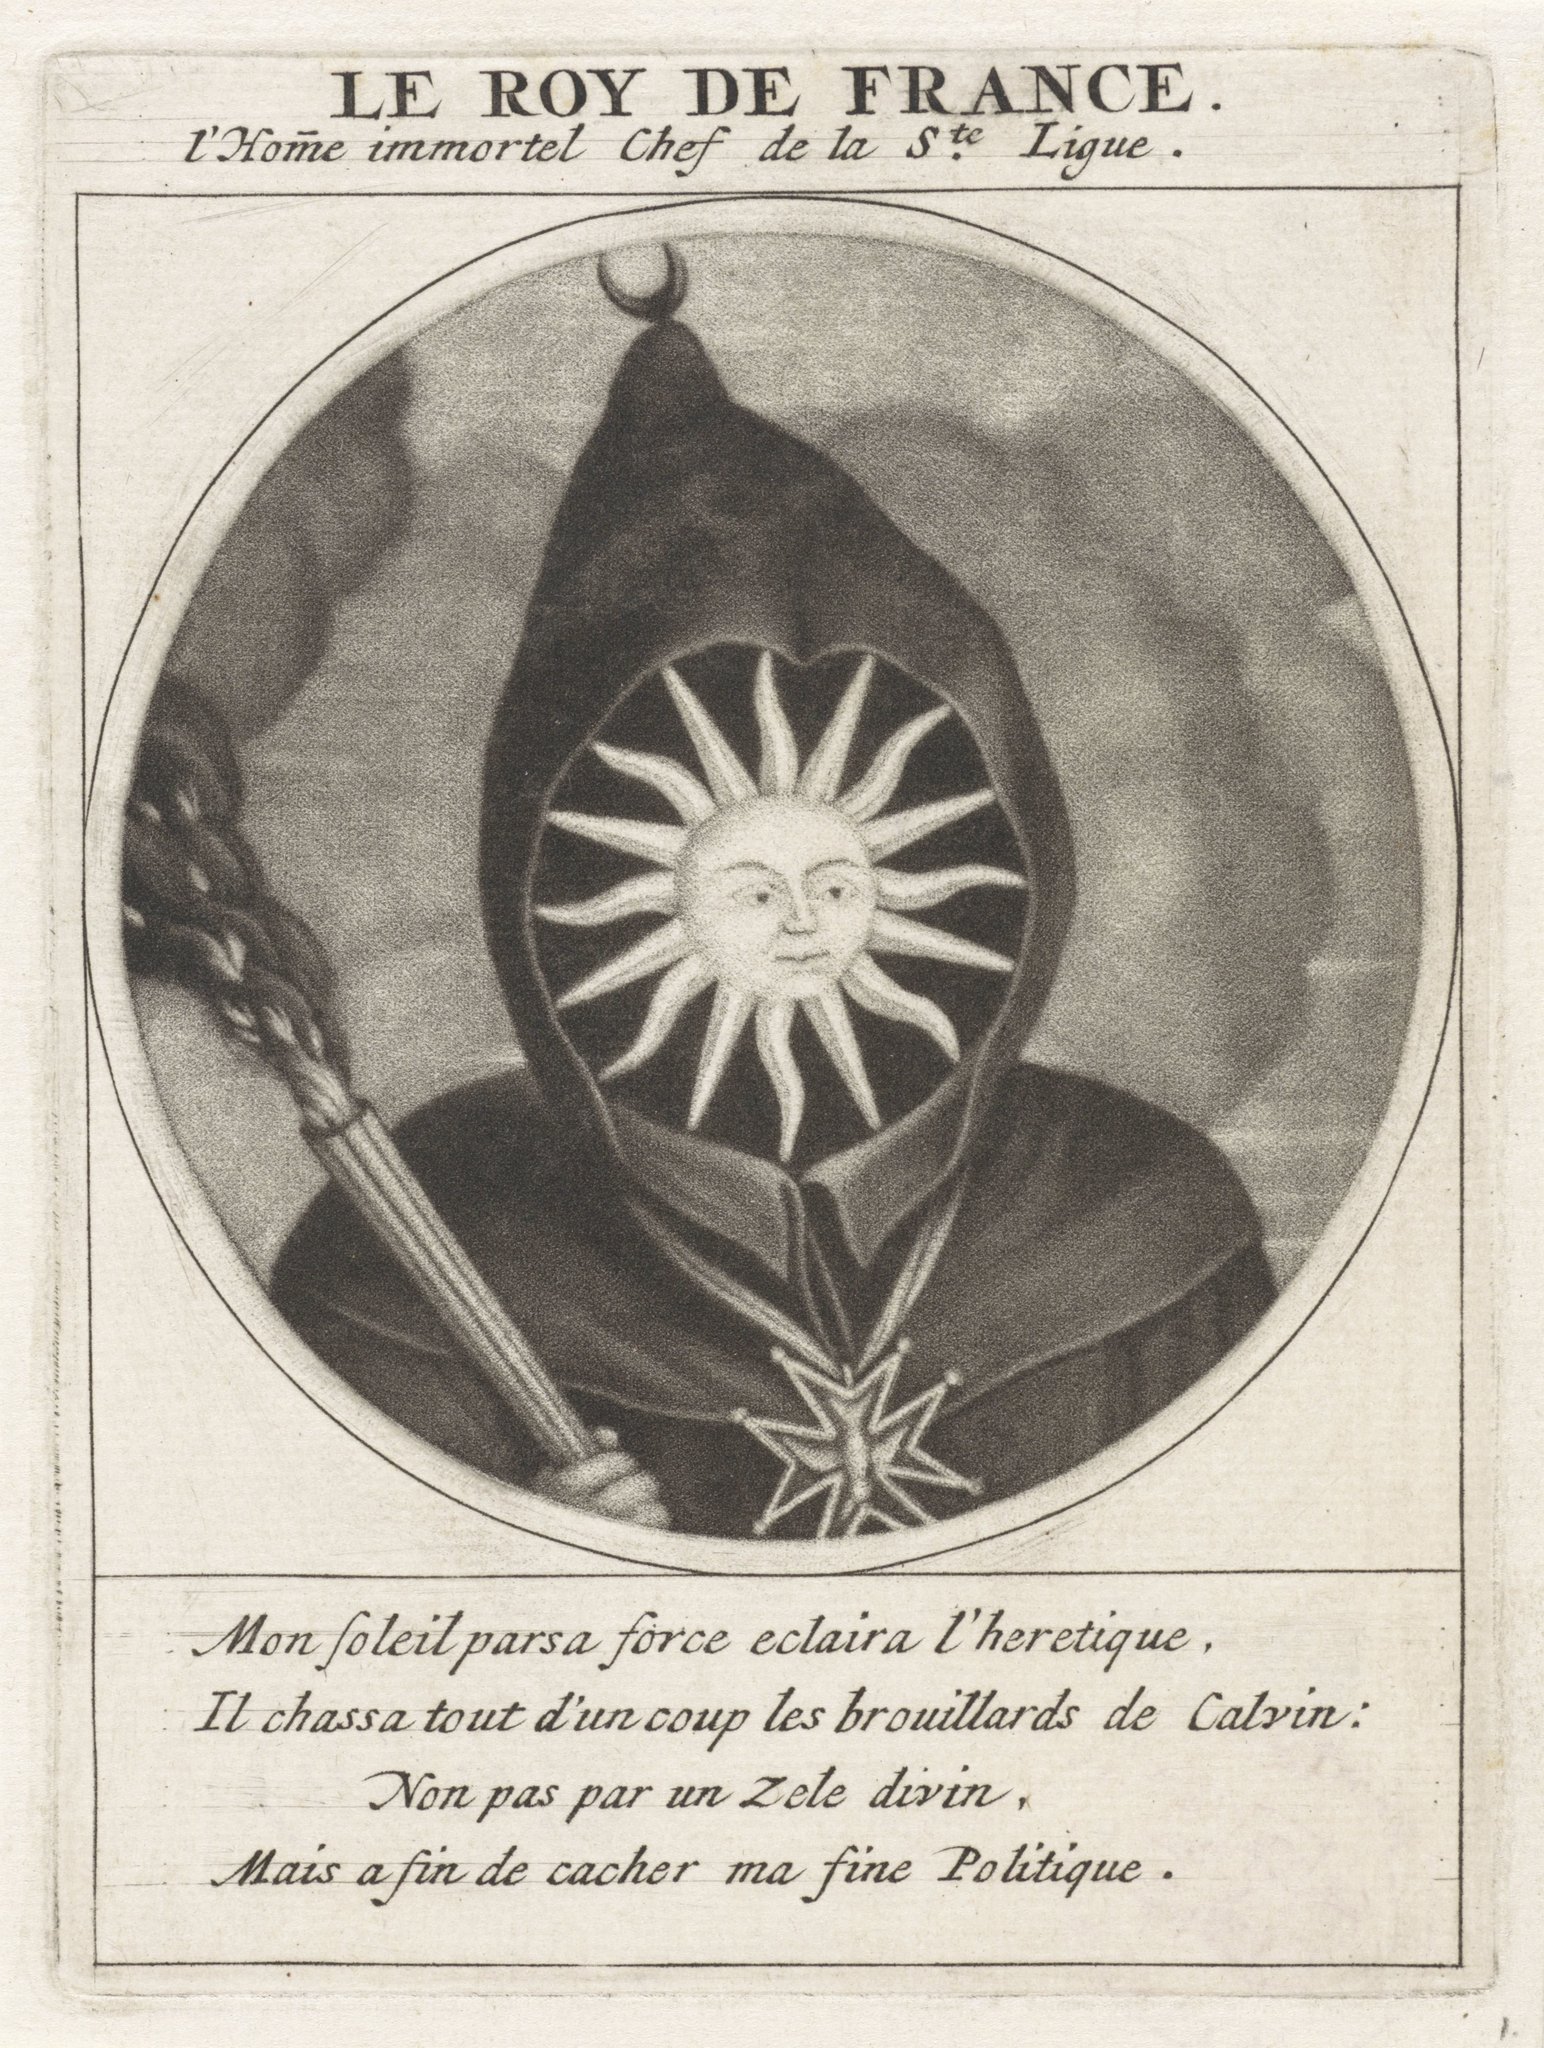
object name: print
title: The Heroes of the League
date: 1691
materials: paper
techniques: engraving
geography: paris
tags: lodewijk xiv (koning van frankrijk), torch, sun represented as face, wheel, etc., political caricatures and satires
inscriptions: collector's mark: Lugt 240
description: Cornelis Dusart and Jacob Gole collaborated on these two series of virulent anti-Catholic caricatures. This one consists of satirical portraits of the architects and agents of the policy of Protestant oppression under Louis XIV. Jacob Gole himself was a Huguenot refugee from France. These champions of Louis’s Catholic politics are presented as monks wrapped up in drinking and dicing.